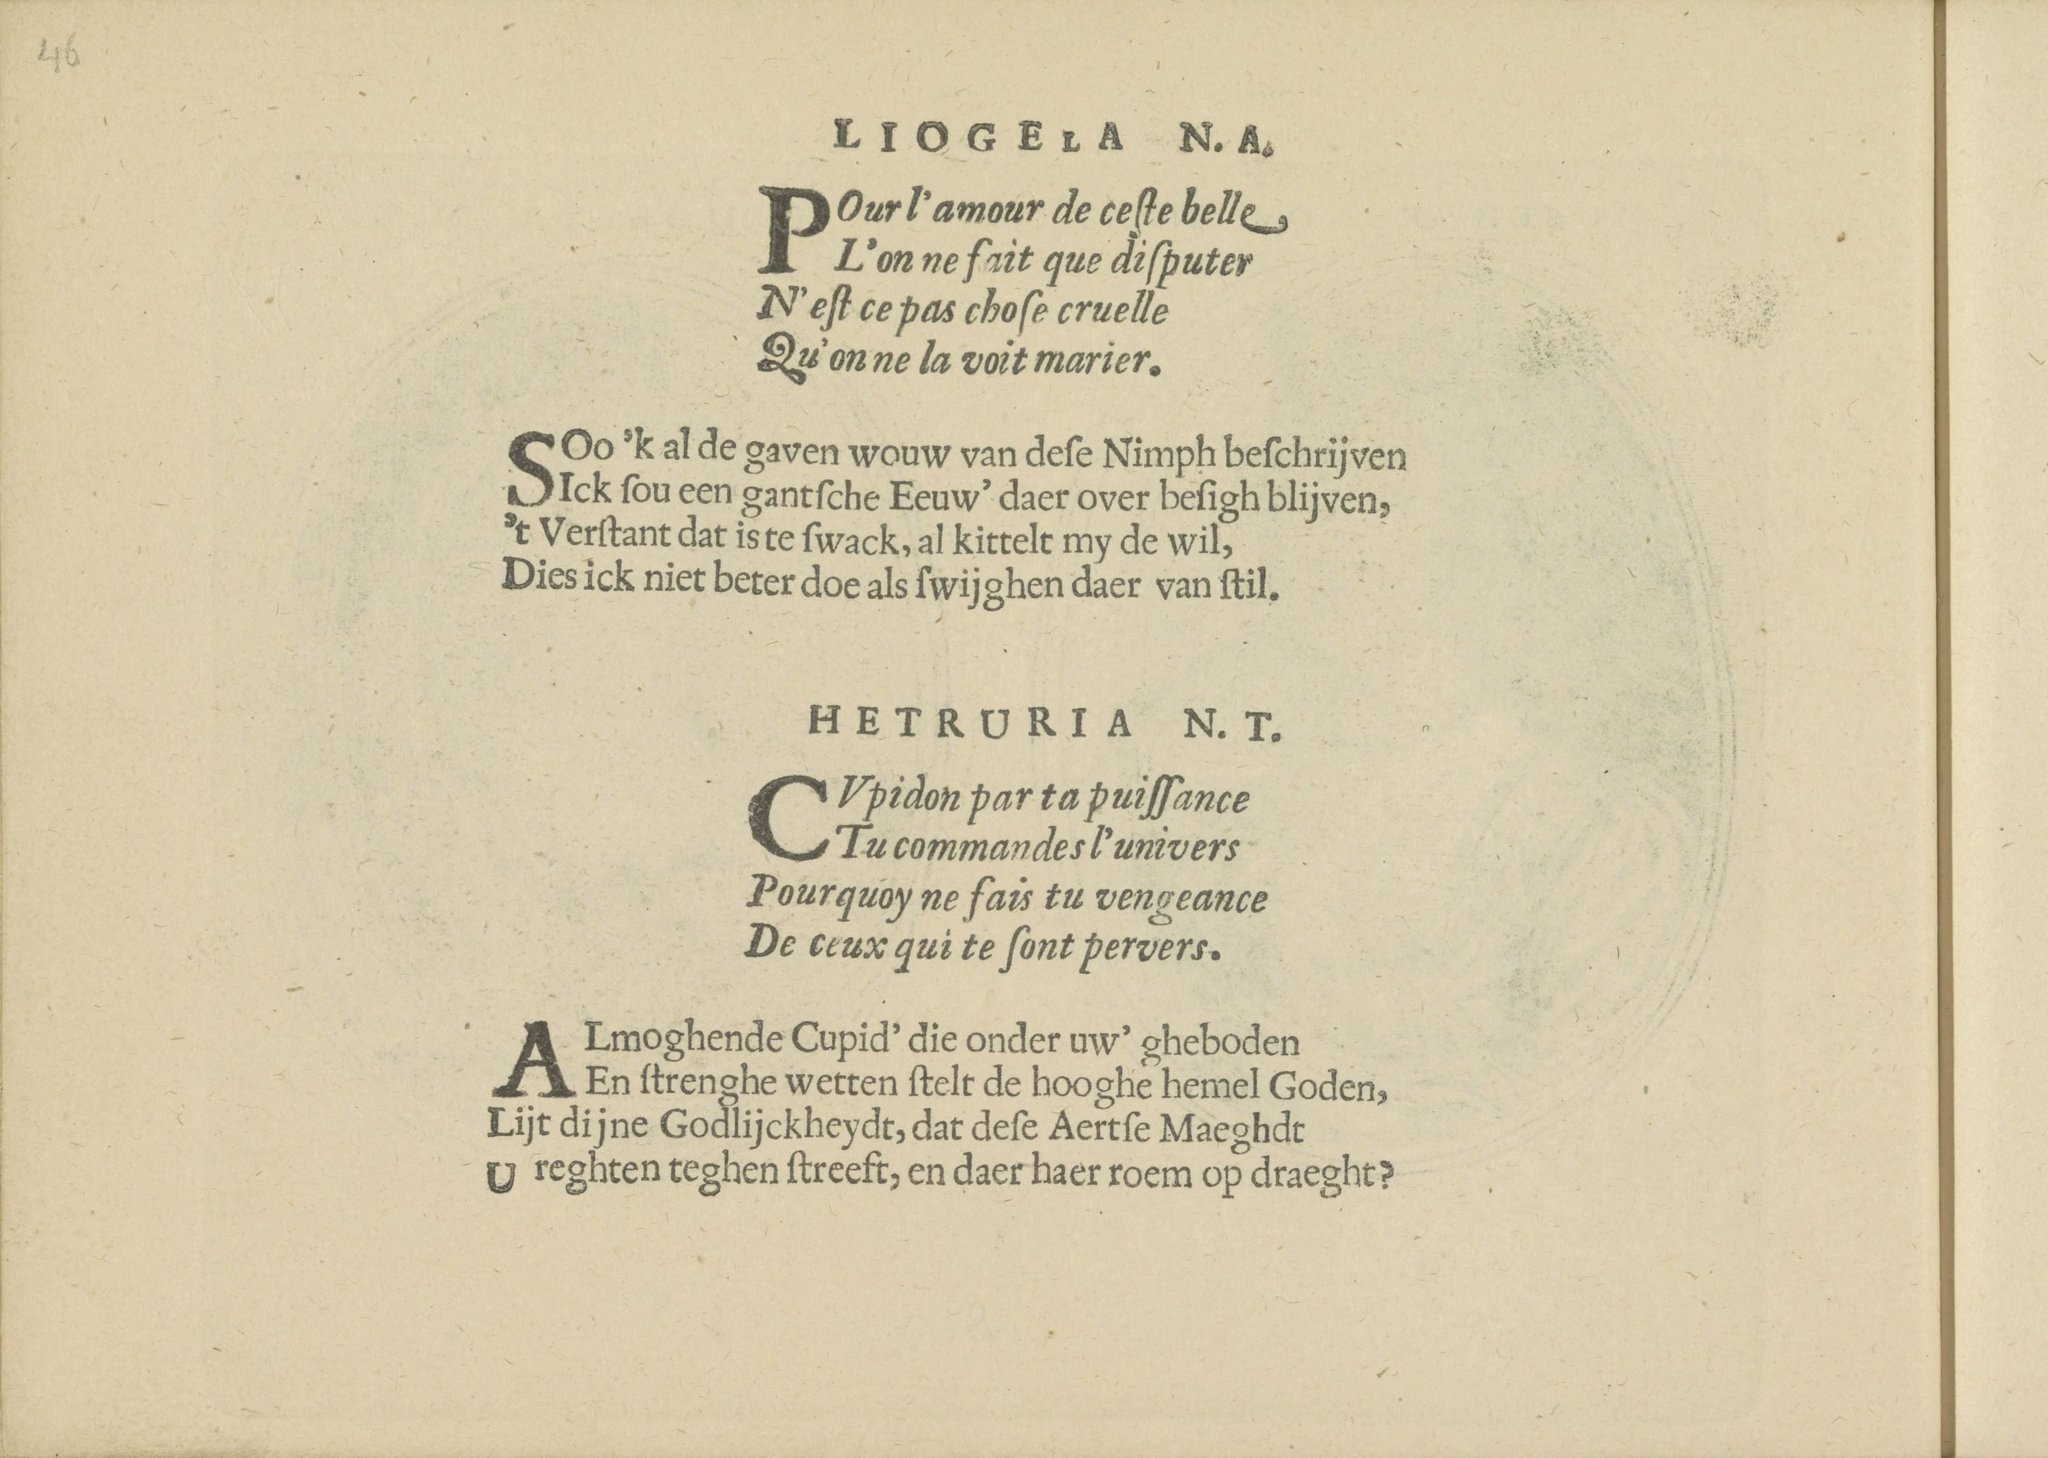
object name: album leaf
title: Les vrais pourtraits de quelques unes des plus grandes dames de la chrestiente desguisees en bergeres.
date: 1640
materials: paper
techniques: letterpress printing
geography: amsterdam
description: Twee keer twee kwatrijnen in het Frans en Nederlands bij de voorstellingen van Liogela N.A. en Hetruria N.T. Het blad maakt deel uit van een album.